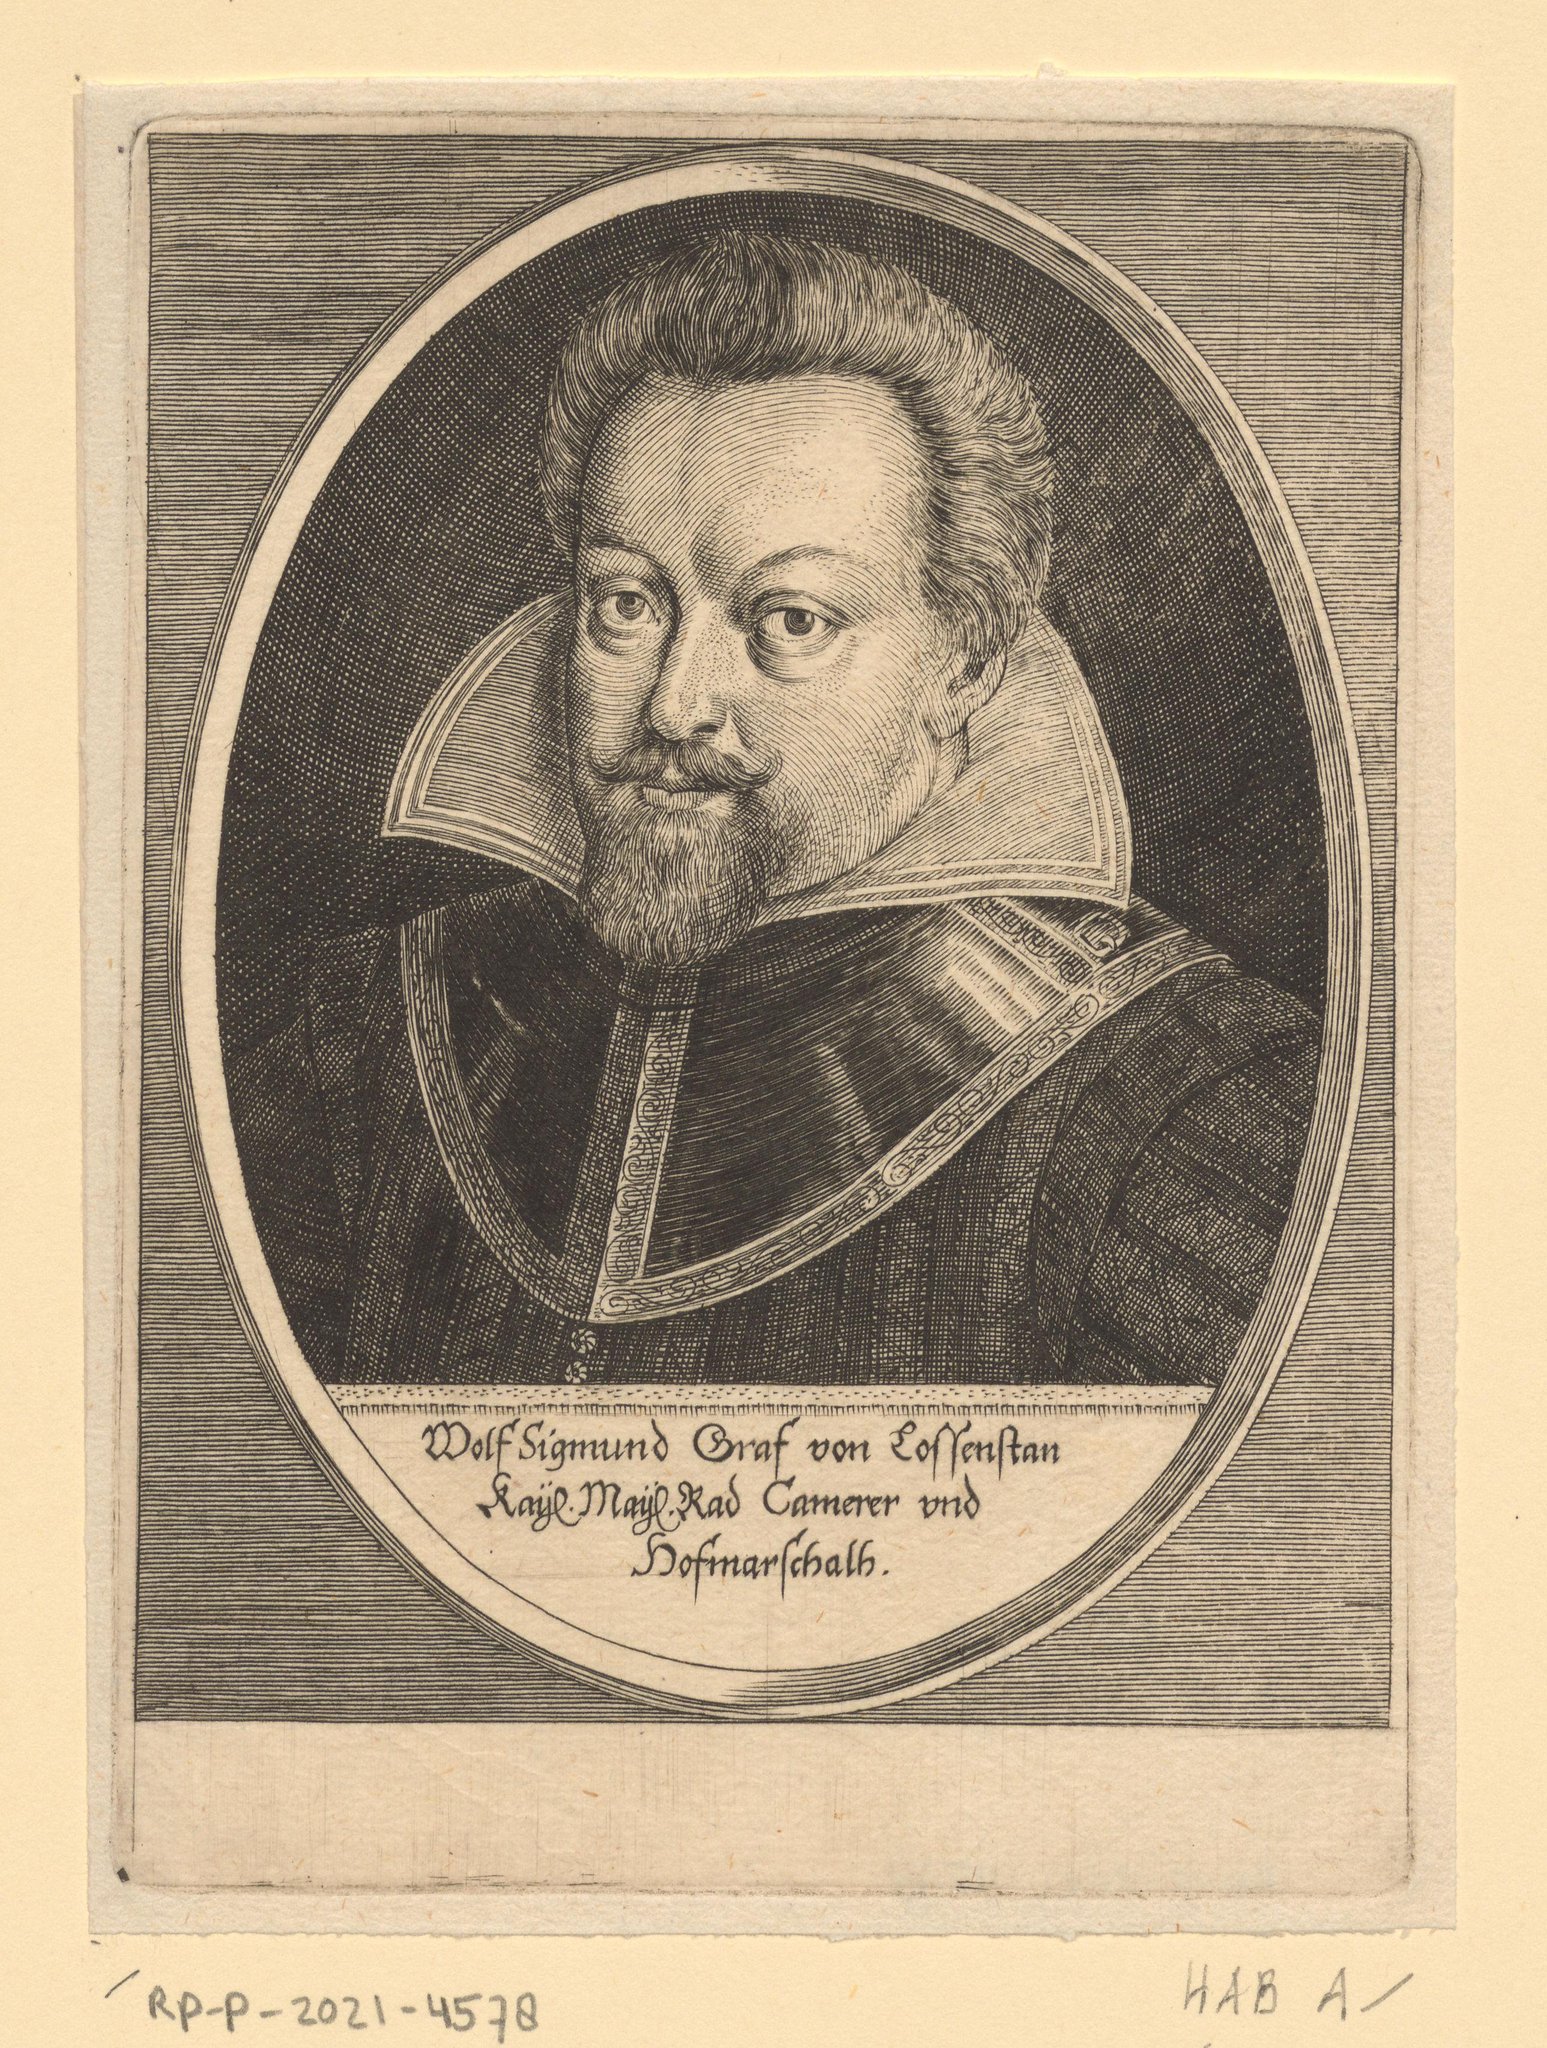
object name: print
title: Portret van Wolfgang Sigismund von Losenstein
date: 1610-1650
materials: paper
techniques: engraving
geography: germany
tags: wolfgang sigismund von losenstein (baron), historical persons